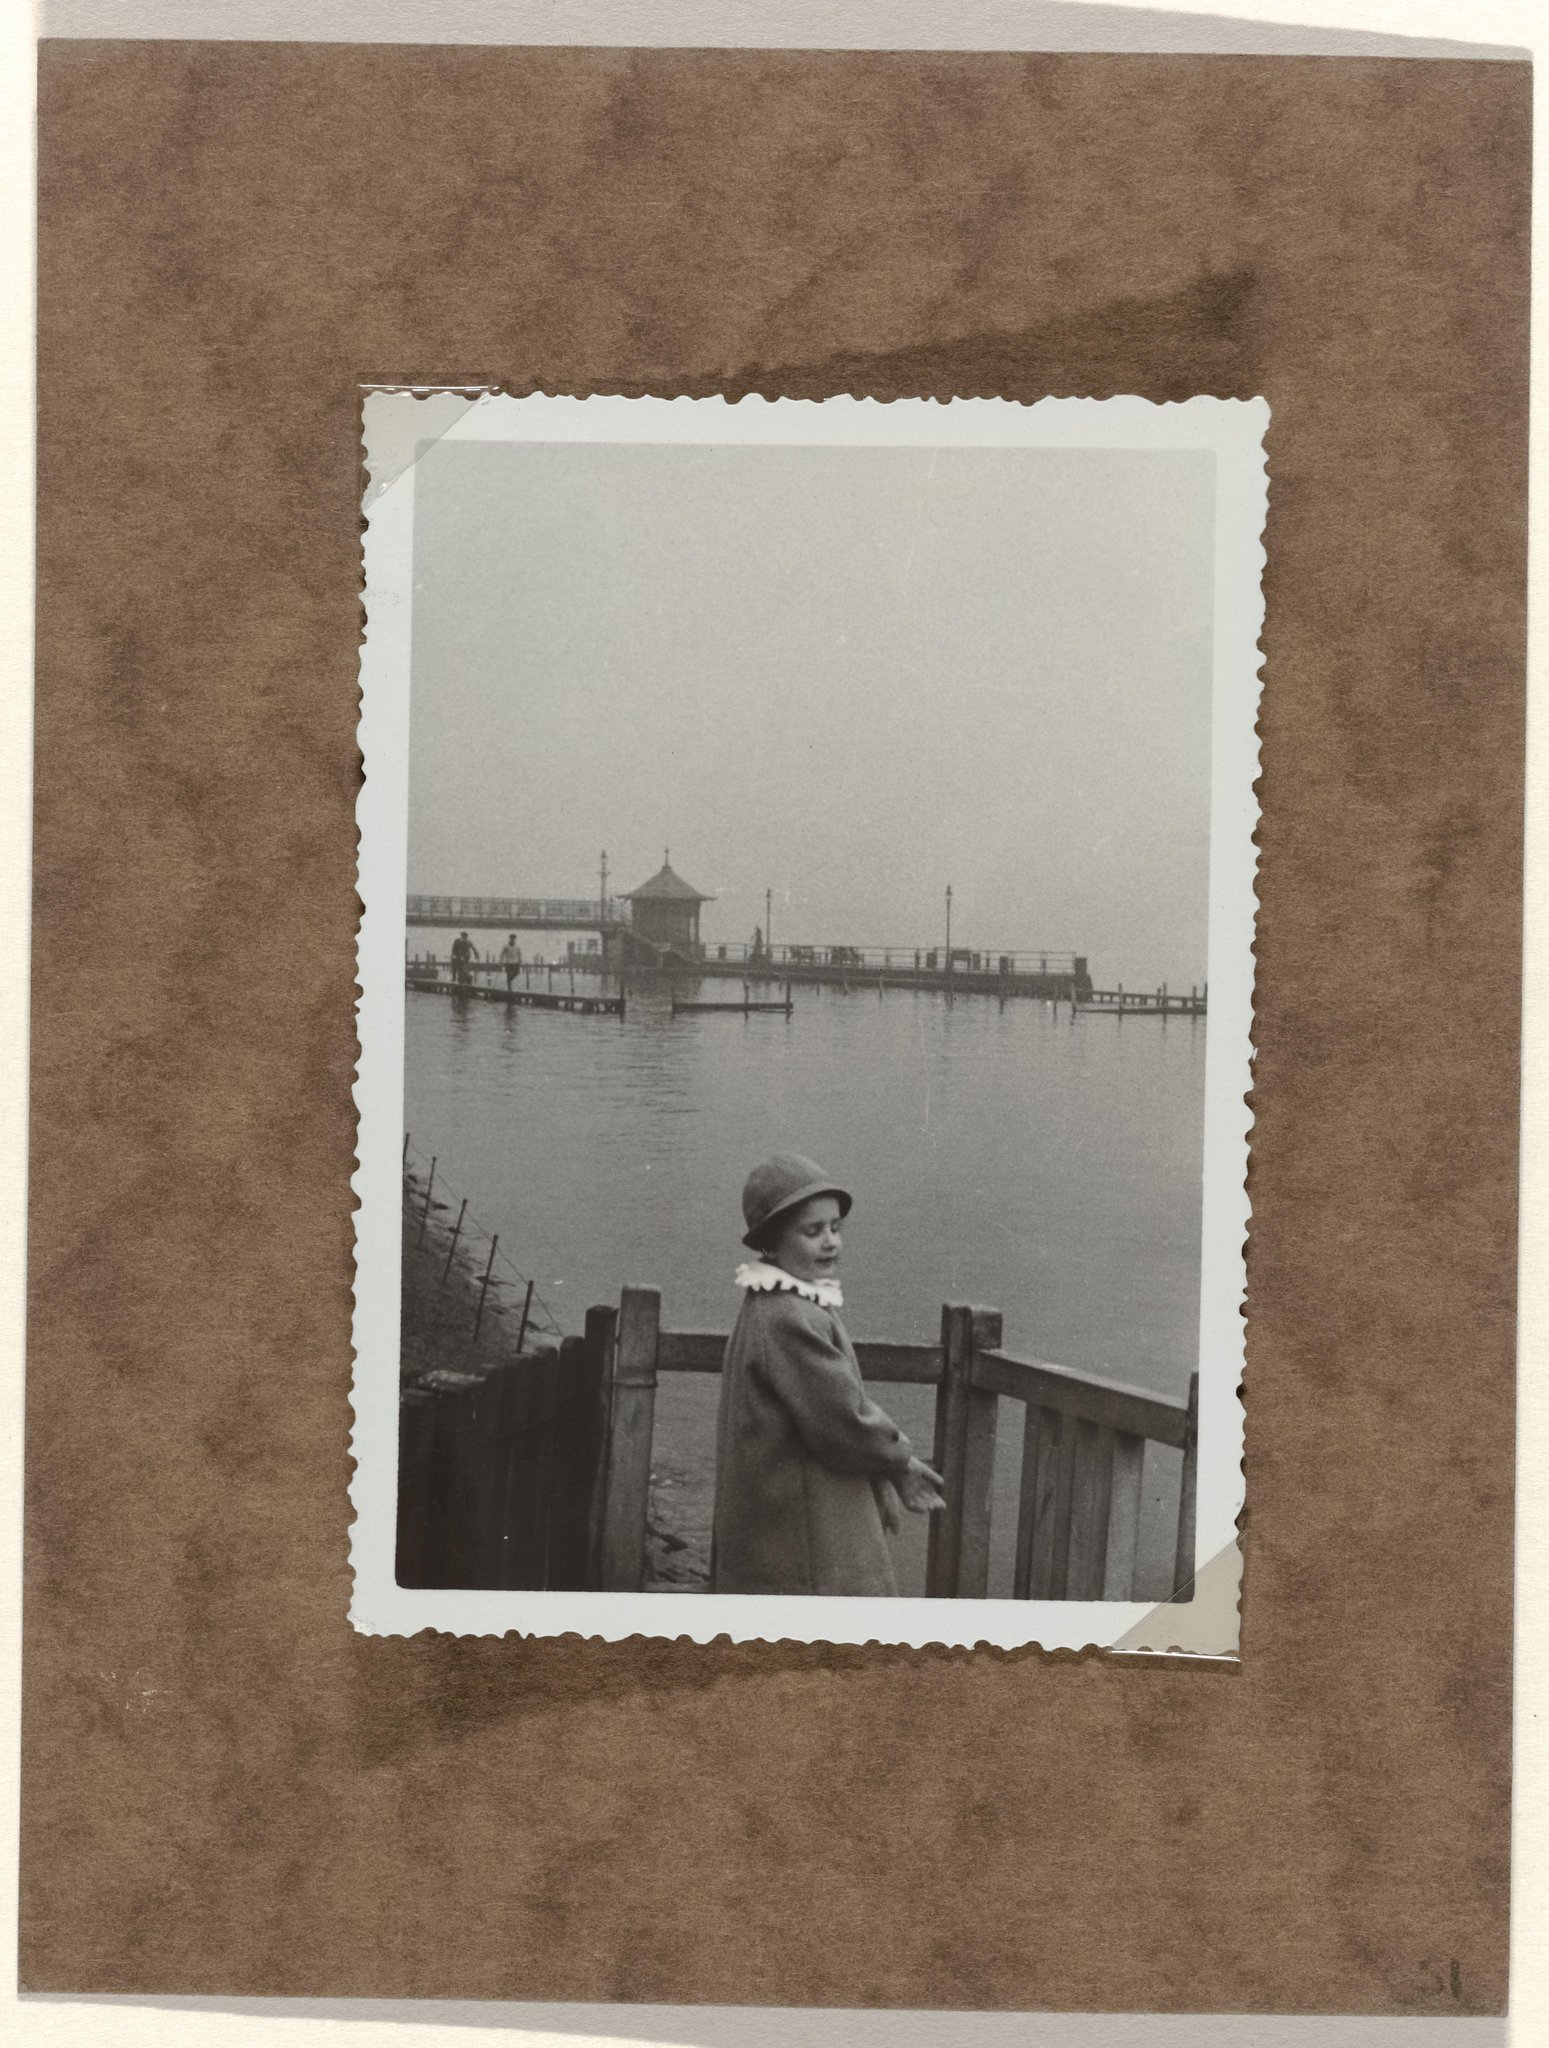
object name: photograph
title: Isabel Wachenheimer aan de rivier de Alster tijdens het bezoek van Isabel Wachenheimer aan haar oom Willy Moos in Hamburg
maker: Anonymous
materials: photographic support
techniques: gelatin silver print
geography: hamburg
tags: isabel wachenheimer-elon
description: Dit object is onderdeel van de nalatenschap van Isabel Elon-Wachenheimer (1928-2010). Tot haar overlijden behoorde het samen met de andere objecten uit de nalatenschap tot haar privédomein van Isabel Wachenheimer. In die particuliere context zijn deze objecten tezamen en individueel aandenkens - aan de jeugd, ouders en familie van Isabel Wachenheimer vóór en tijdens de Shoah en aan haar leven na de Tweede Wereldoorlog. Isabel Wachenheimer, die van juni 1943 tot mei 1945 gevangen zat in Kamp Westerbork, Theresienstadt, Auschwitz, Lenzing a/d Oberdonau (een buitenkamp van Mauthausen), overleefde de Shoah. Haar ouders – Eugène Wachenheimer en Else Wachenheimer-Moos - werden op 14 oktober 1944 in Auschwitz-Birkenau vermoord.